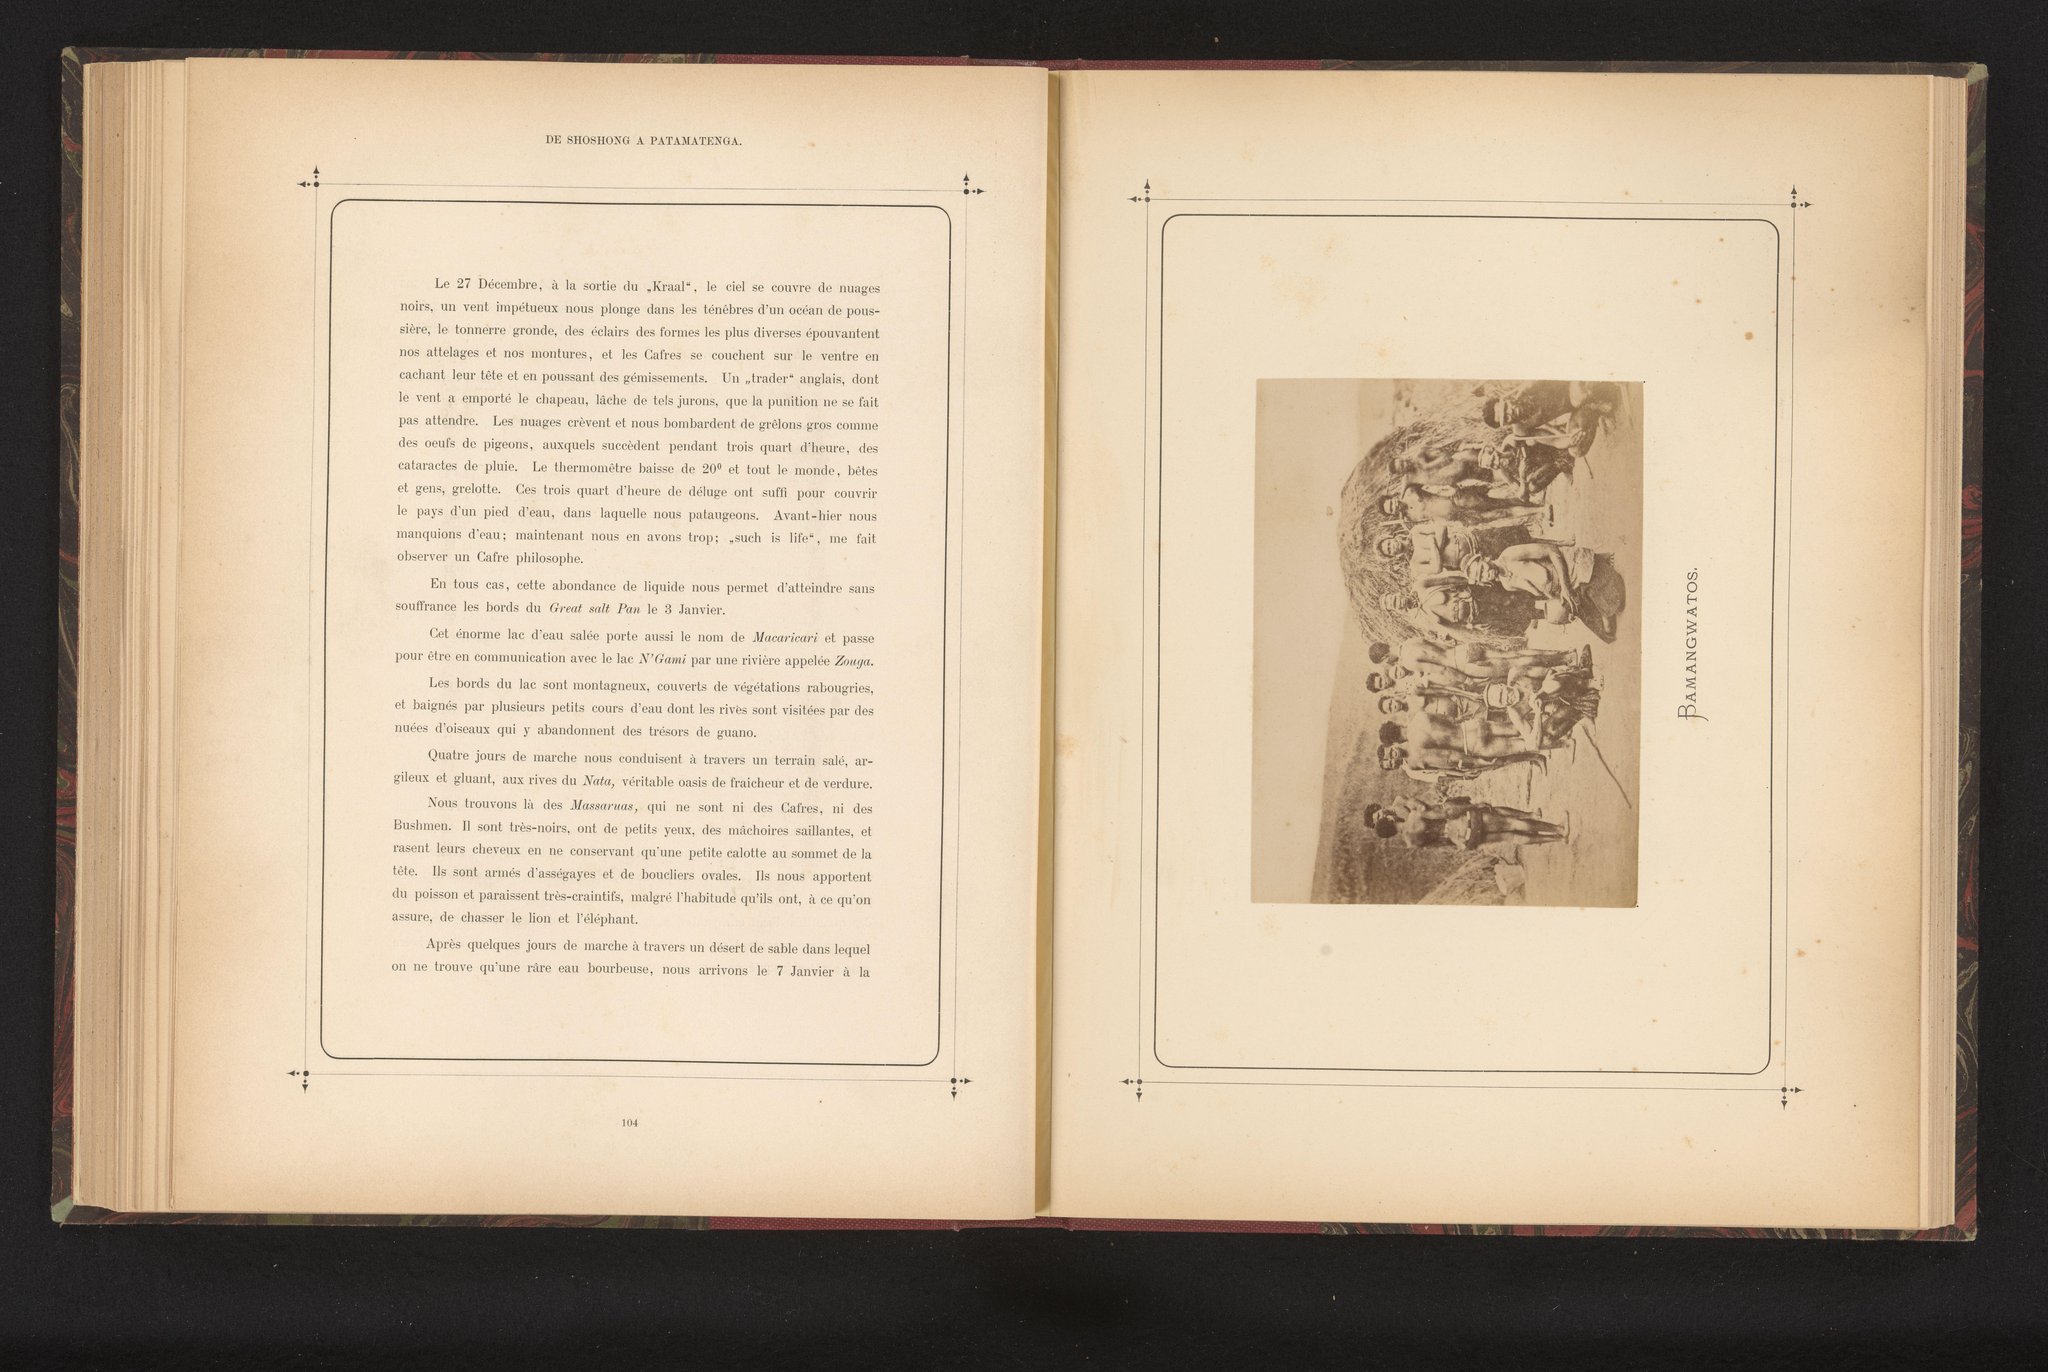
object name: page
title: Bamangwato-mensen in Botswana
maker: Anonymous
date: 1879-1884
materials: paper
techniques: albumen print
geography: botswana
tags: africans